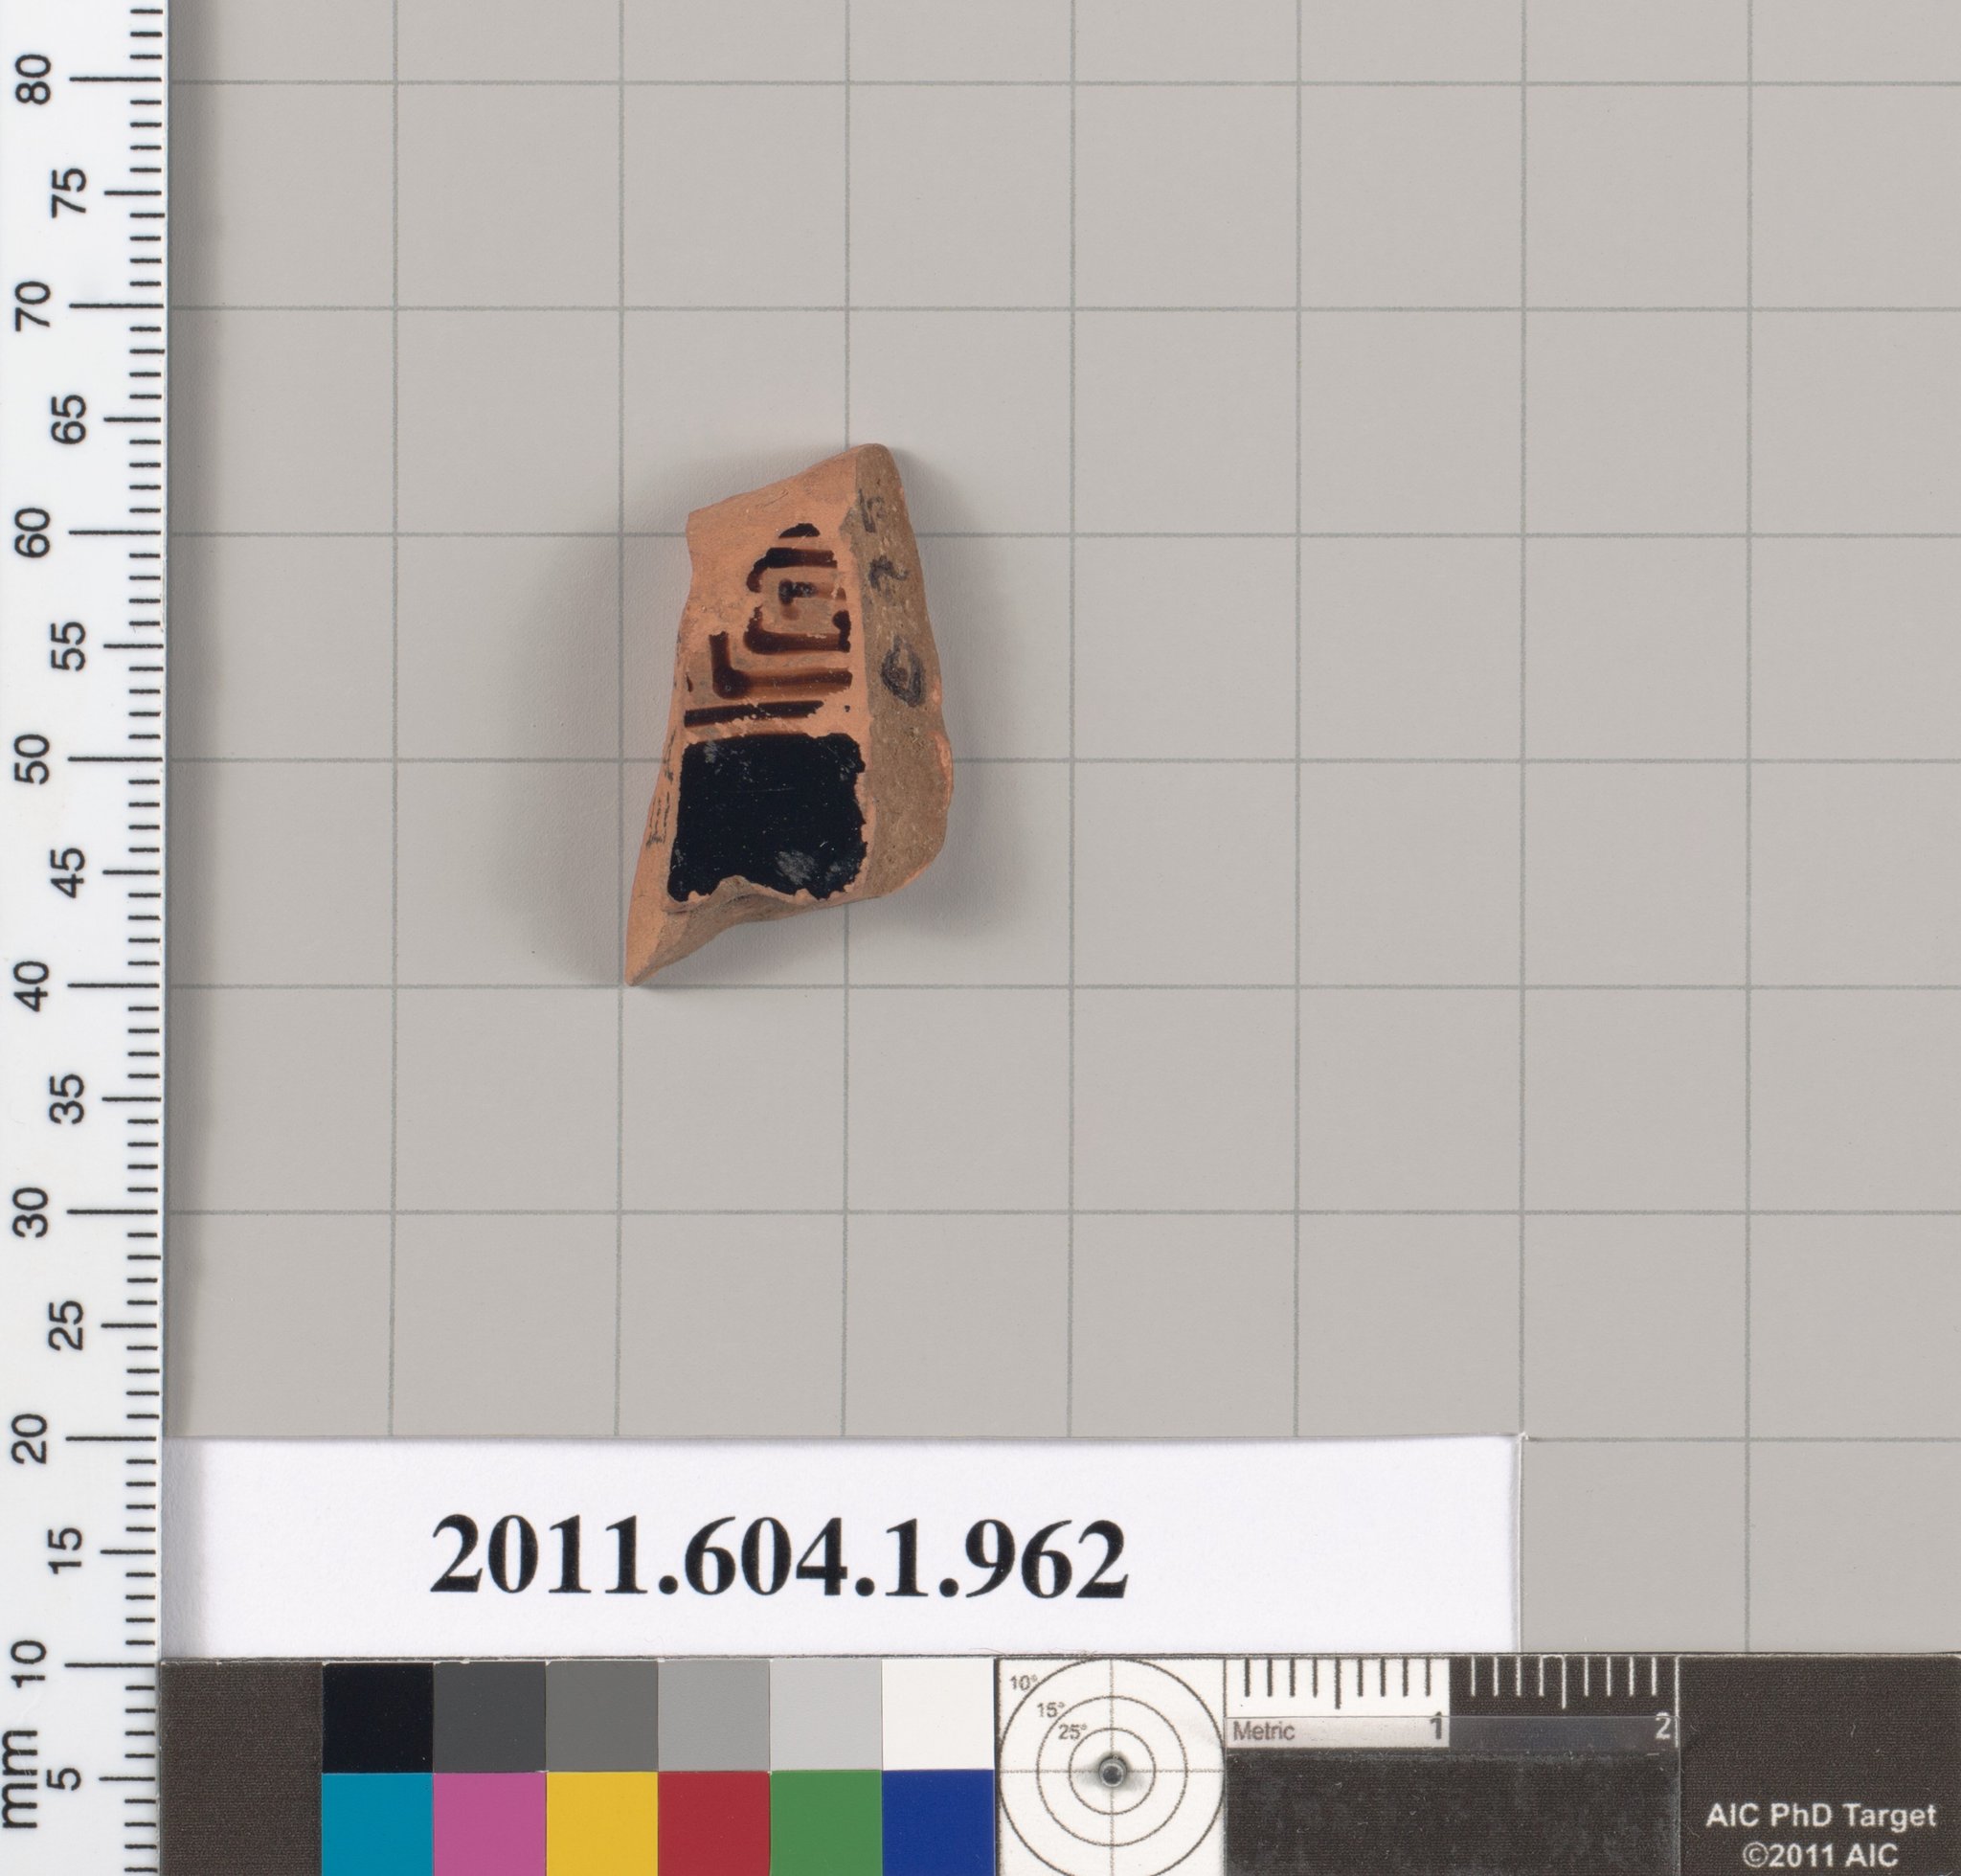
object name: kylix fragment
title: Terracotta fragment of a kylix (drinking cup)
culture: greek, attic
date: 490-480 BCE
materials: terracotta